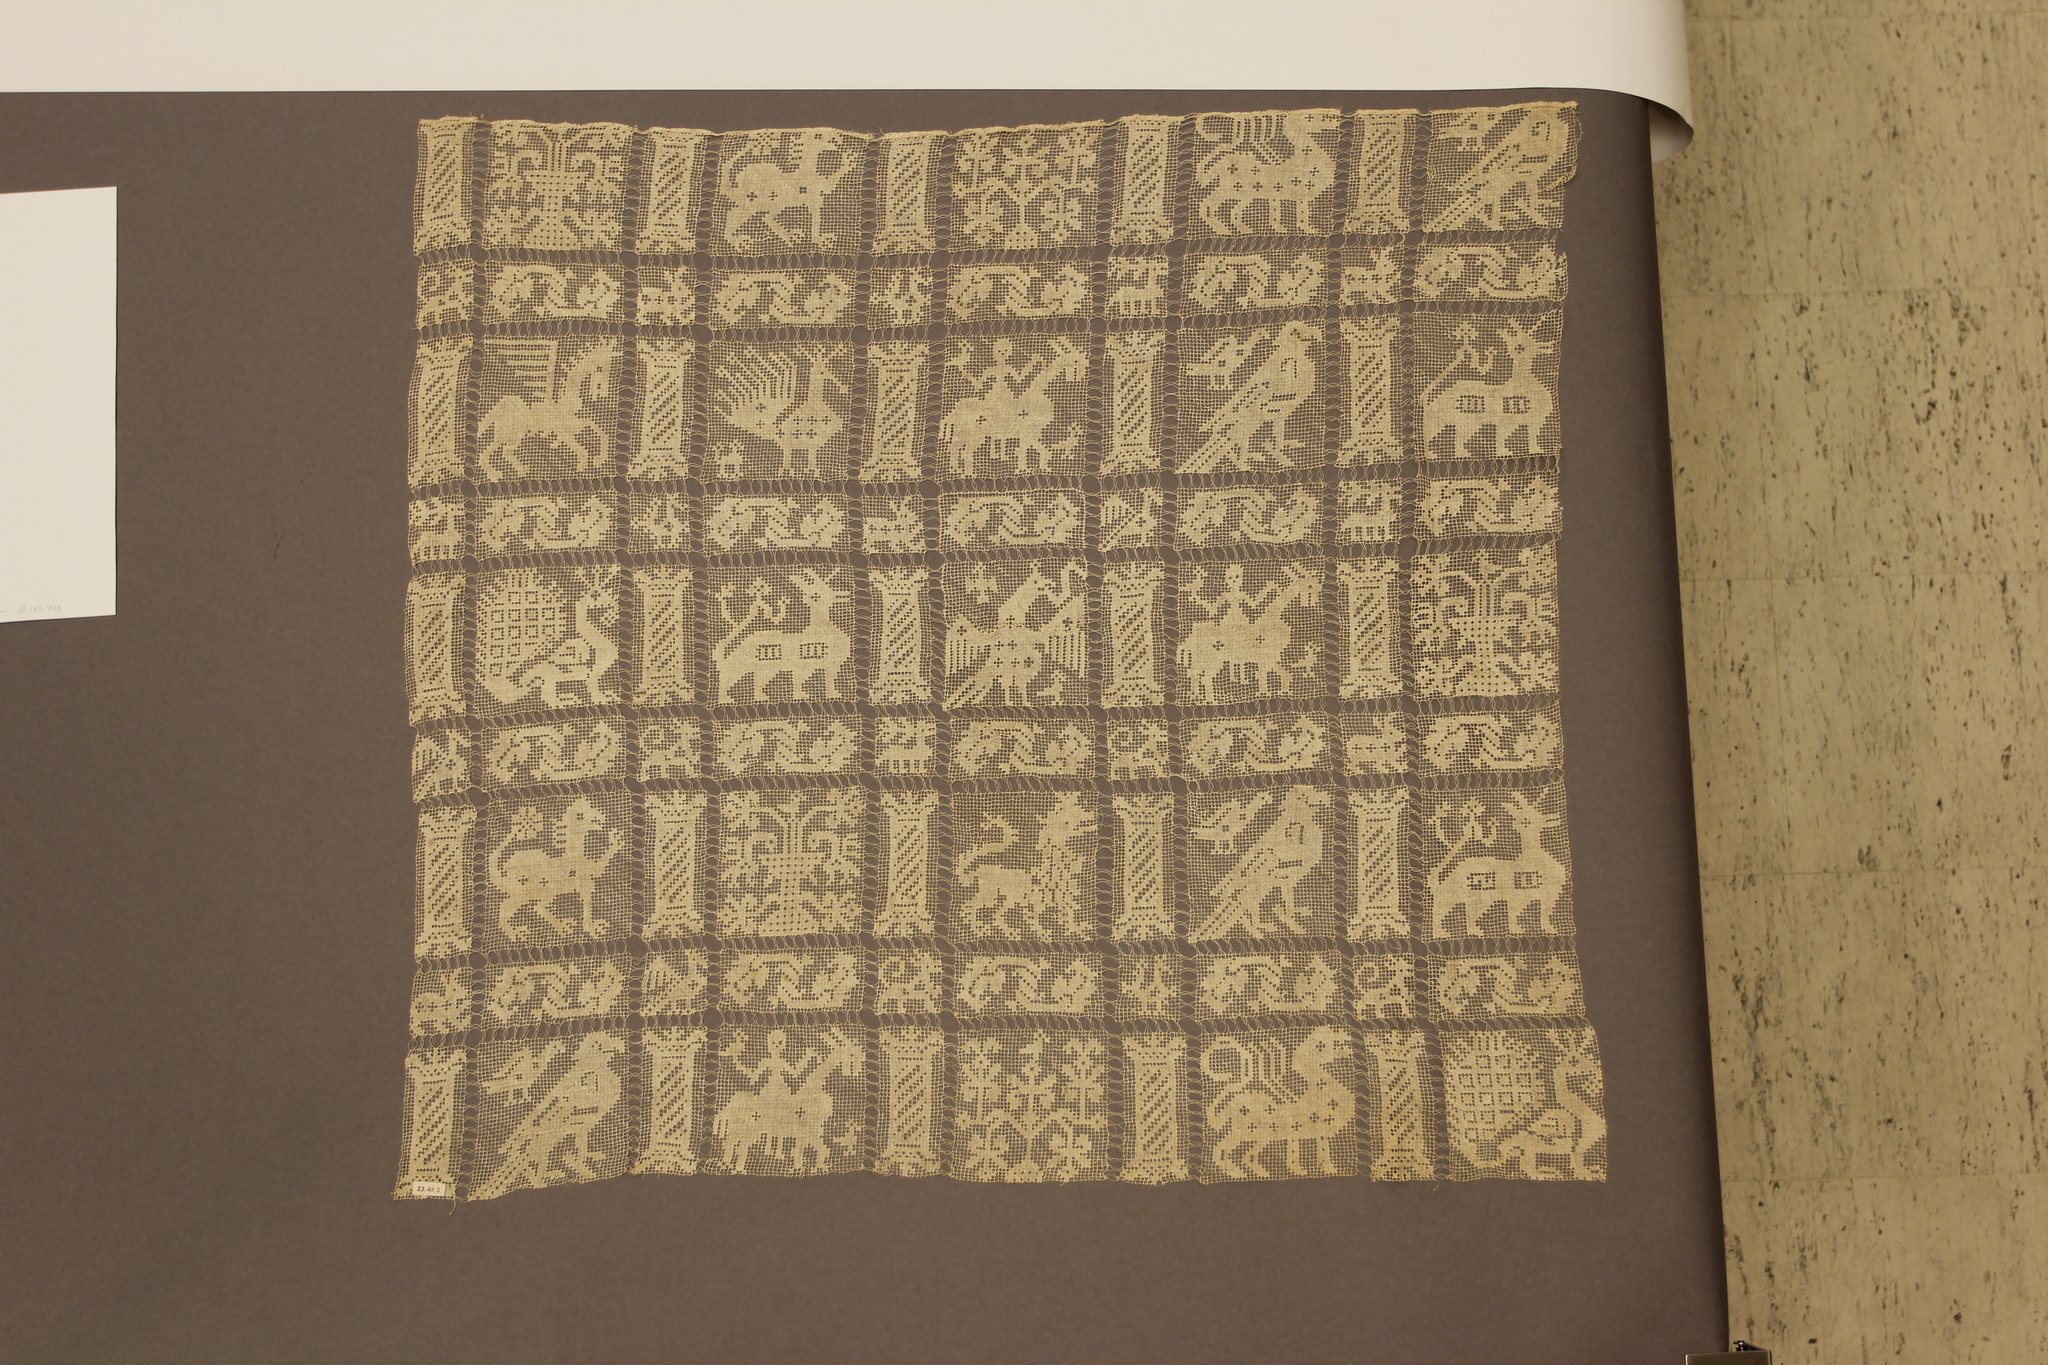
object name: panel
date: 1601-1633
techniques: embroidery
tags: animals,birds,peacocks